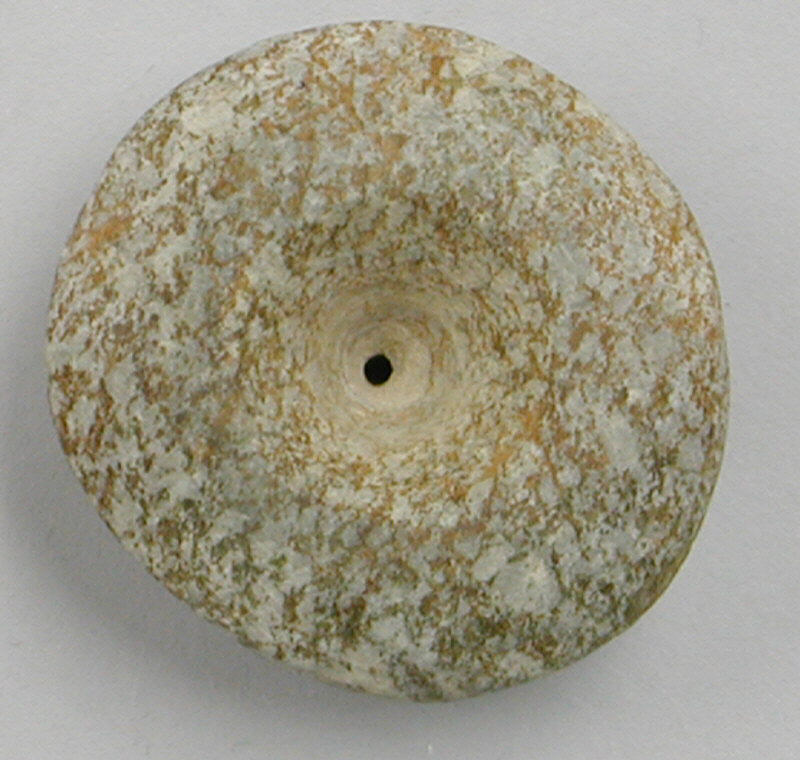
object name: weight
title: Stone Weight or Bead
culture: mexican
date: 1501-1600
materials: stone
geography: mexico